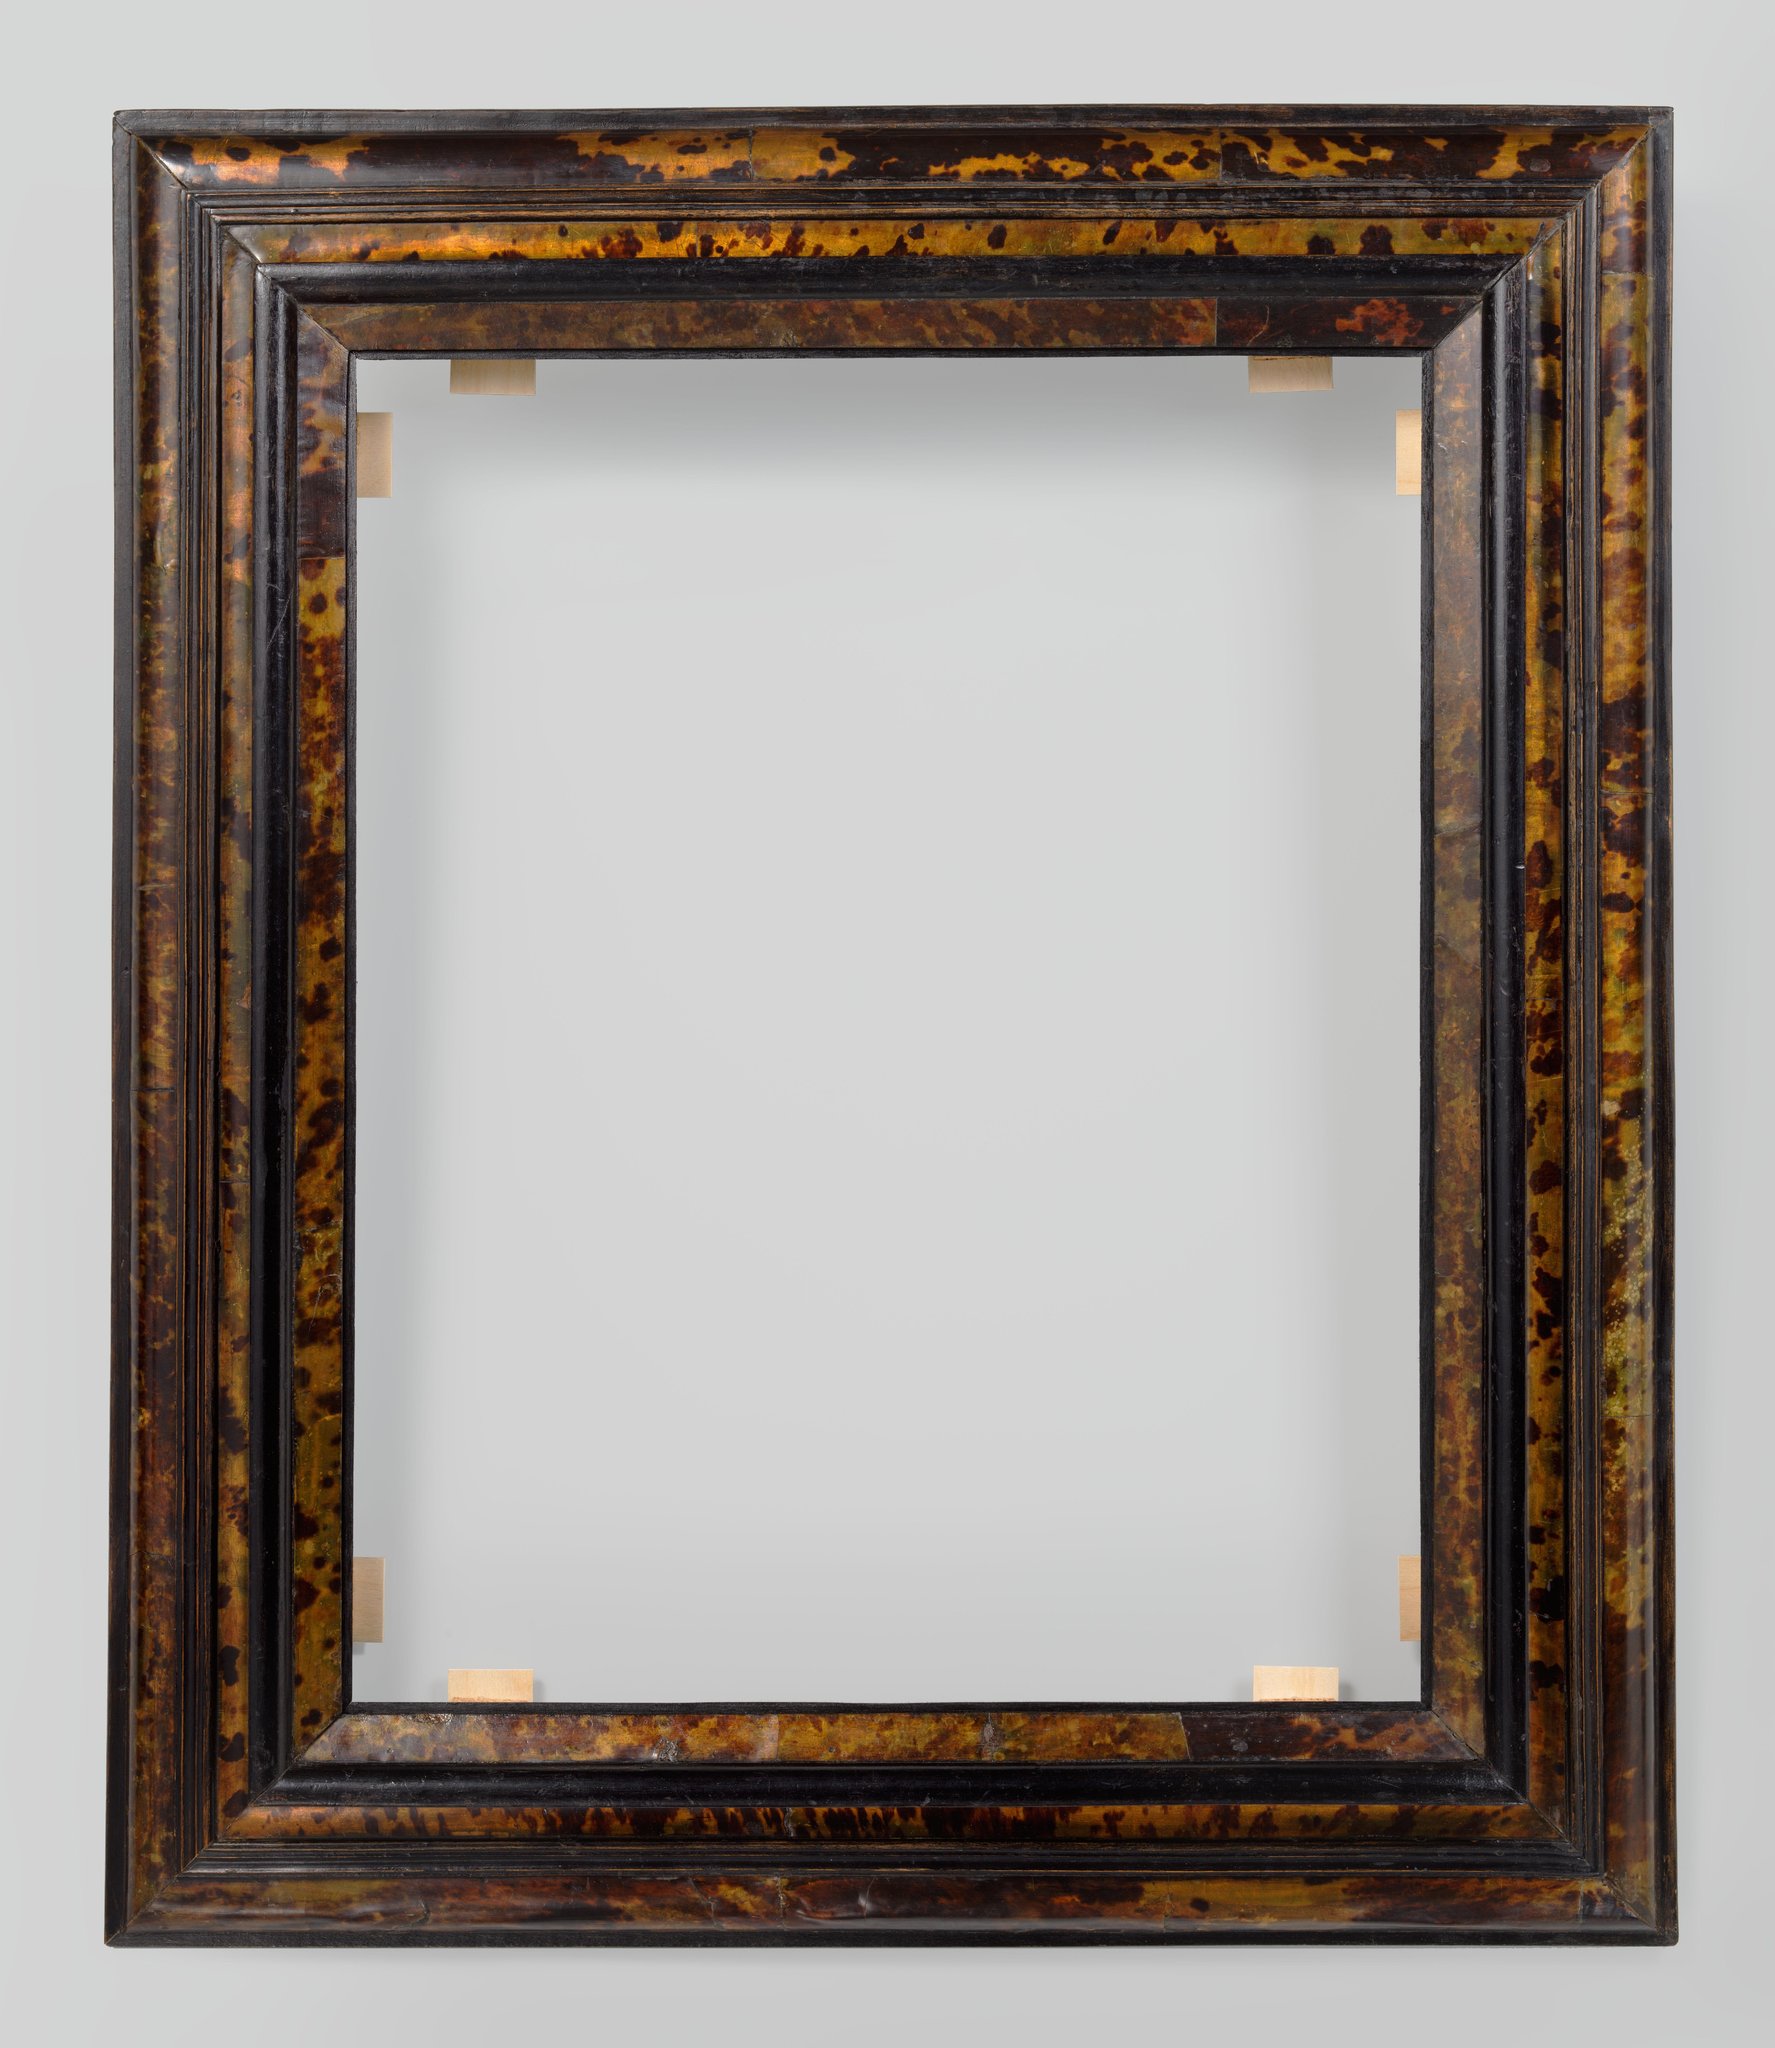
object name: frame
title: Schildpadlijst met renversé profiel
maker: Anonymous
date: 1700-1899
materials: gold leaf, leaf, paper, shell, wood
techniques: gilding, veneering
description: Schildpadlijst met renversé profiel met zwart geverfde profileringen. Onder het schildpad is het hout bedekt met verguld papier De hoeken hebben een pen- en gat verbinding. Het smalle rechte latje aan de buitenrand lijkt een latere toevoeging.